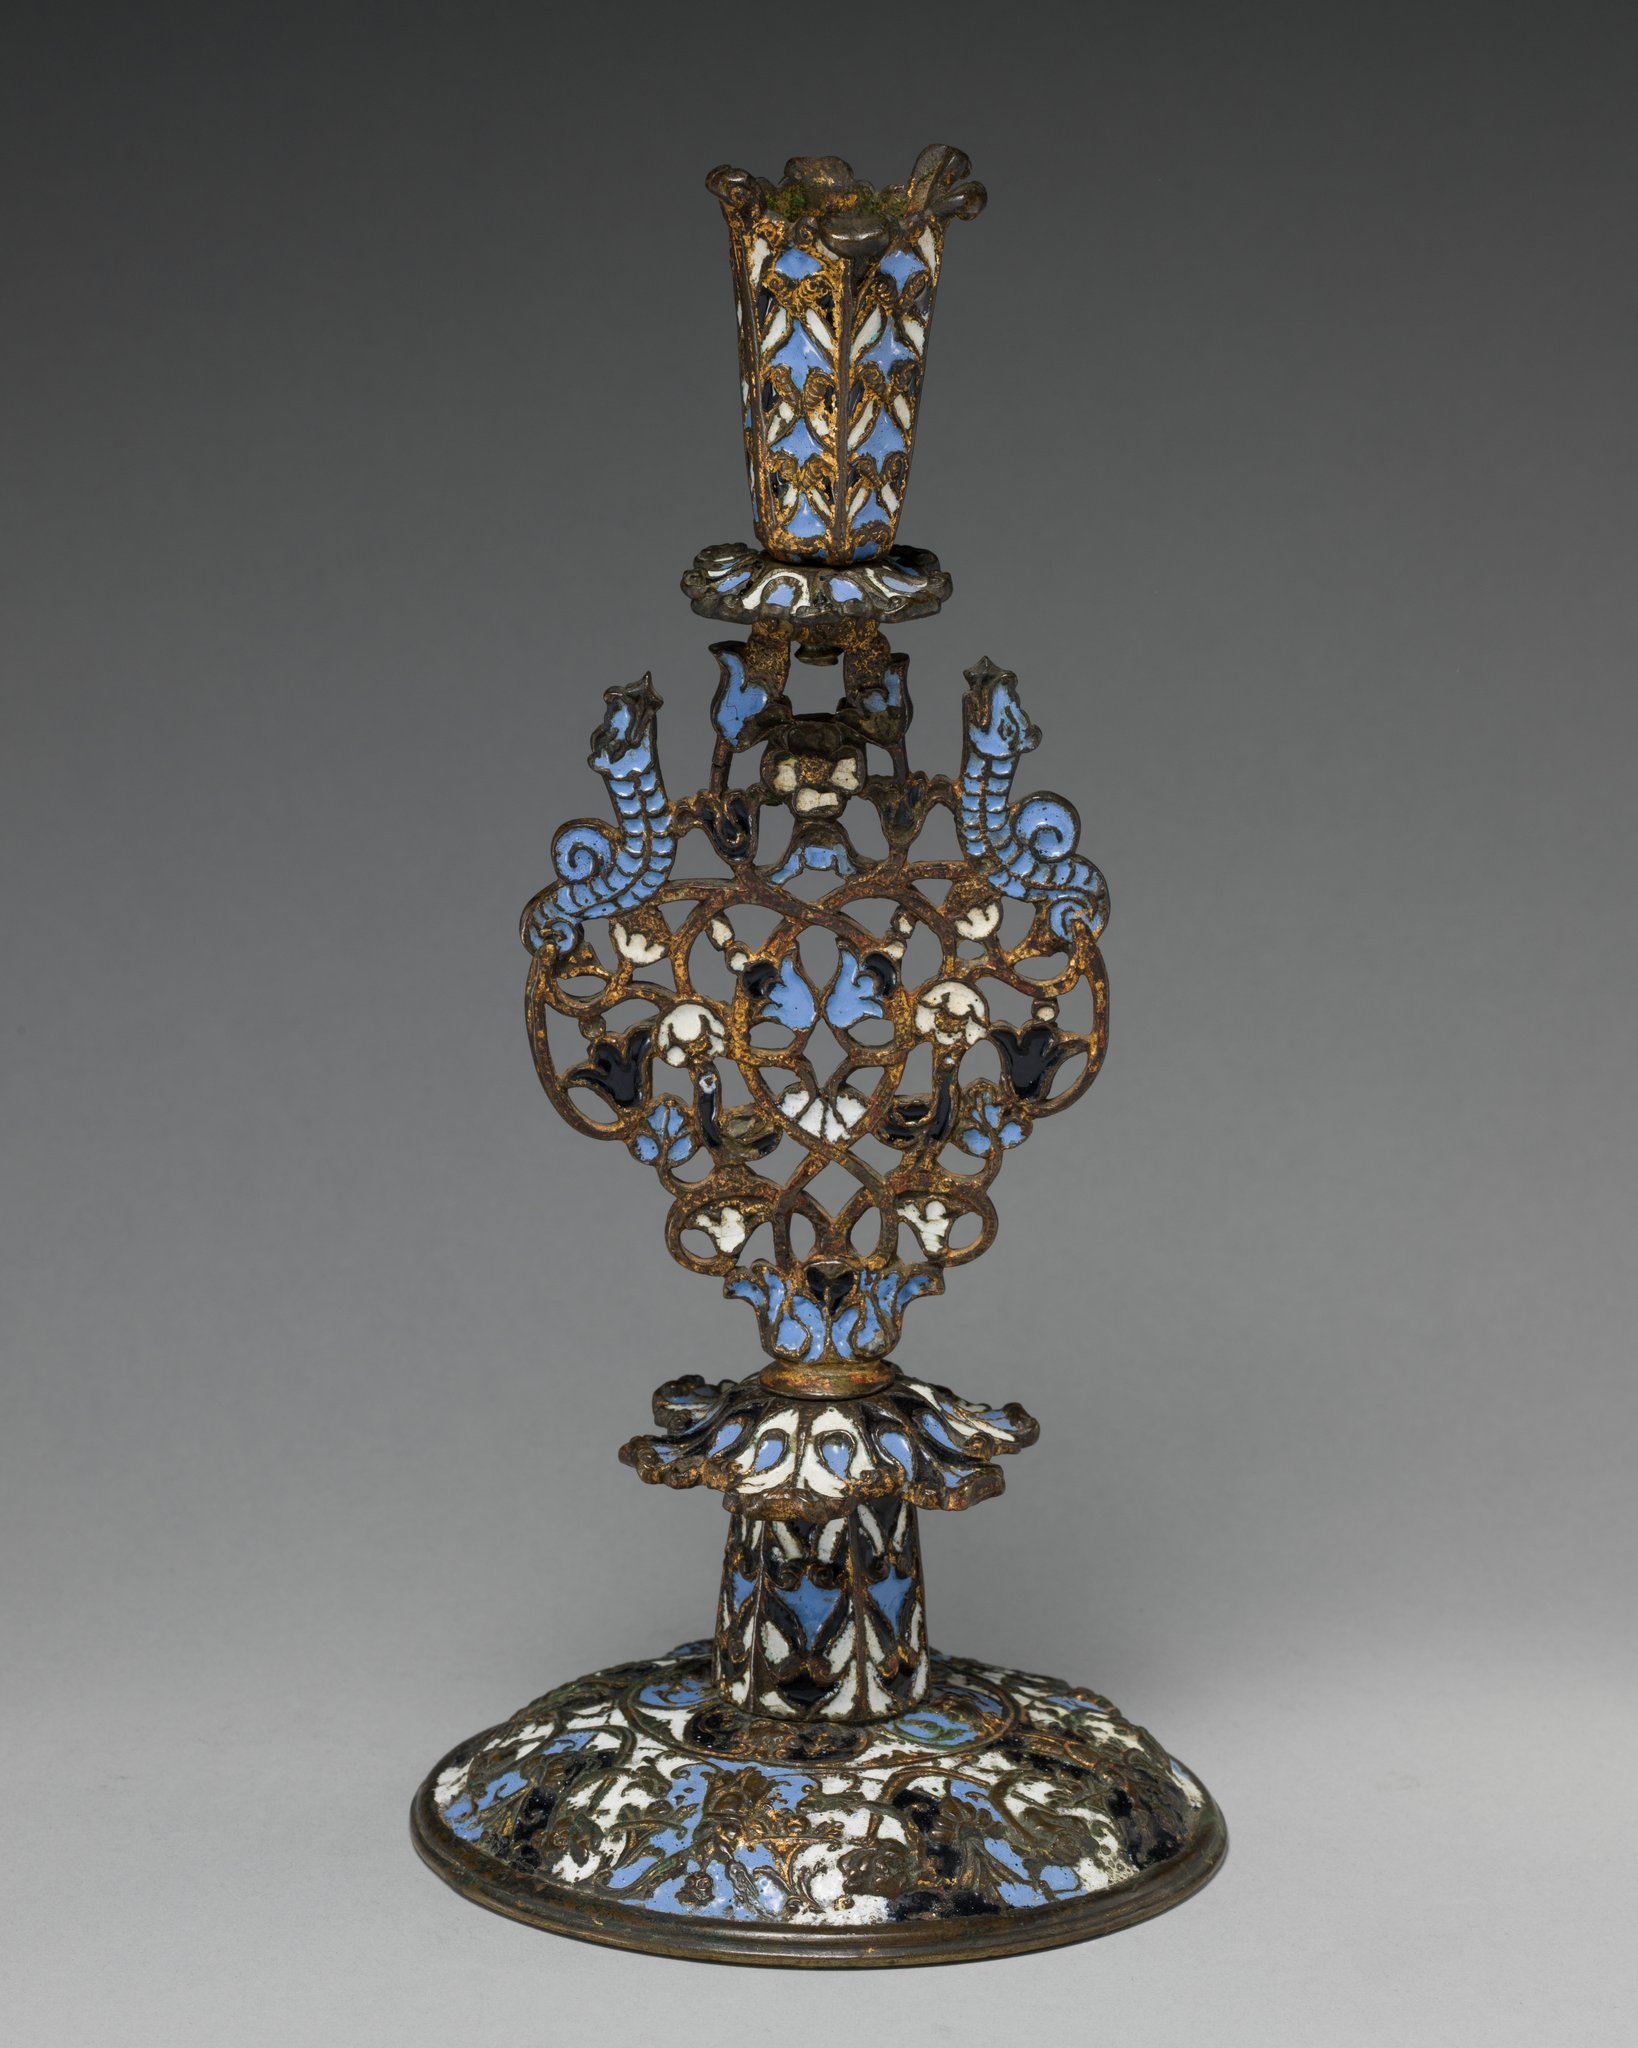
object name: candlestick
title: Candlestick (one of a pair)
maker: stephen pilcherd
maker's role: maker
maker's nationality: british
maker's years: 1570-1670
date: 1660-1680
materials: brass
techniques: enamel, gilding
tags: dragons